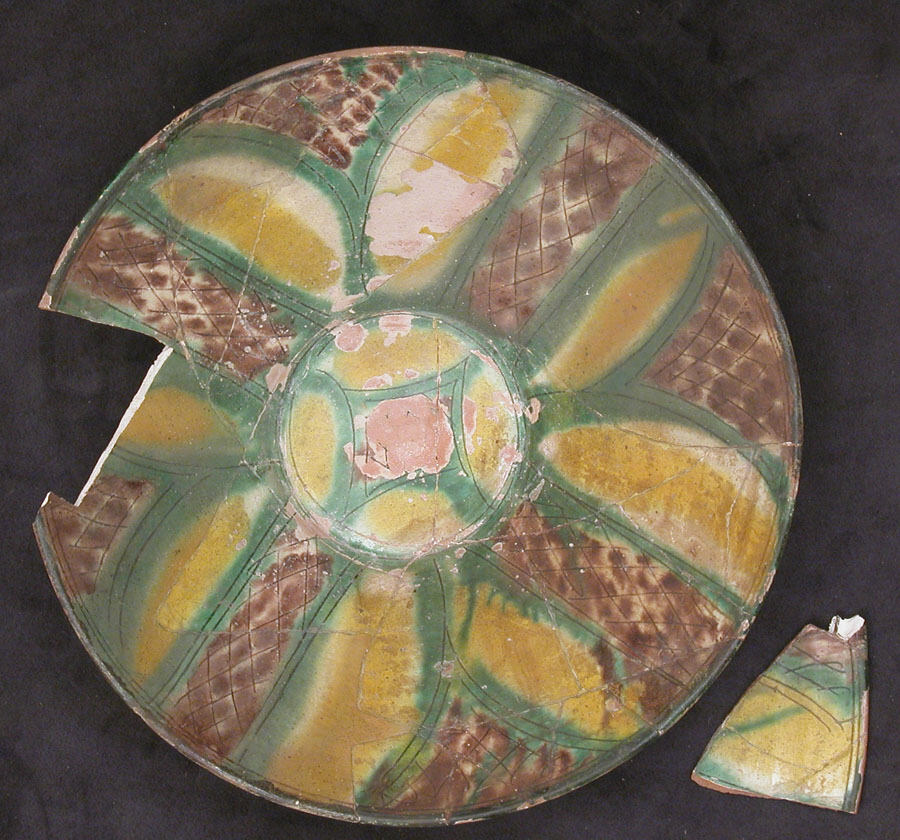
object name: bowl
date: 801-1000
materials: earthenware, glaze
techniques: polychrome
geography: iran